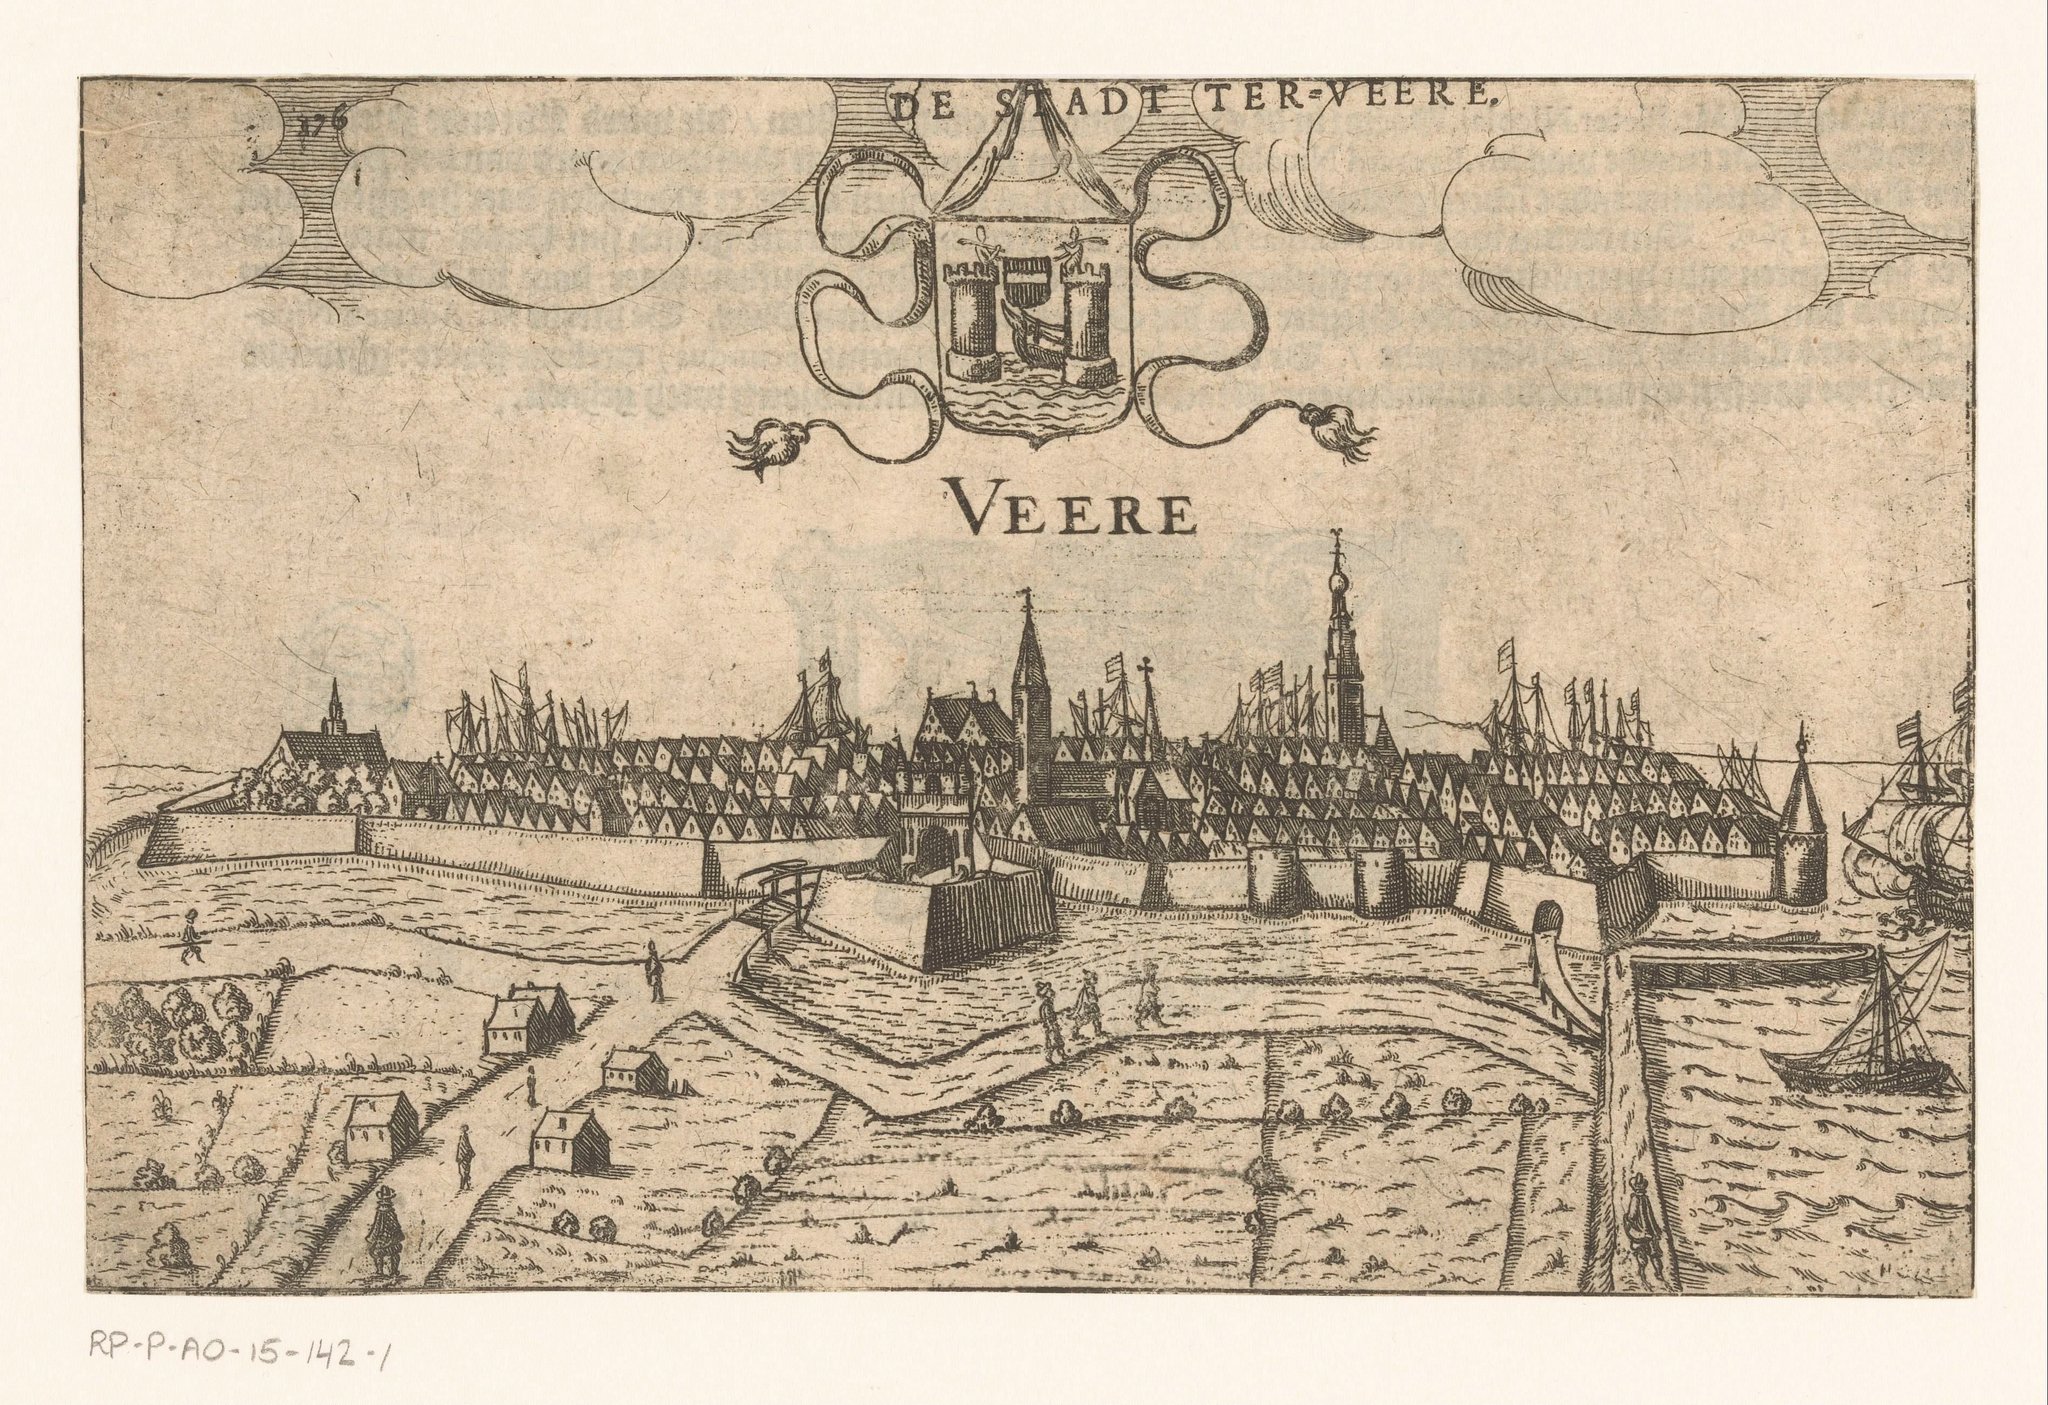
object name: book illustration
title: Gezicht op Veere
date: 1615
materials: paper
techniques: etching, letterpress printing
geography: arnhem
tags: coat of arms (as symbol of the state, etc.) (+ city; municipal), prospect of city, town panorama, silhouette of city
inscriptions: collector's mark: Lugt 195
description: Prent gebruikt in: Petit, Jean François le. Nederlantsche Repvblycke, bestaende inde staten so generale, als particuliere van 't hertochdom Gelder, graefschap van Hollant, West-vrieslandt, ende van Zeelandt, provincien van Utrecht, Vrieslant, Over-IJssel ende van Groeninghen (…). Arhnem: Jan Jansz., 1615, p. 176.